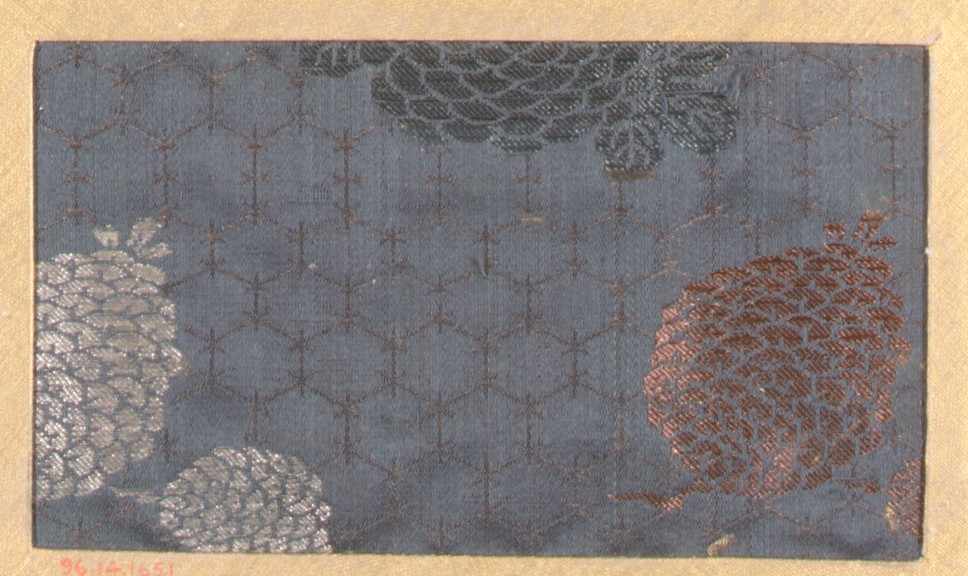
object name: piece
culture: japanese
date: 1701-1900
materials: silk